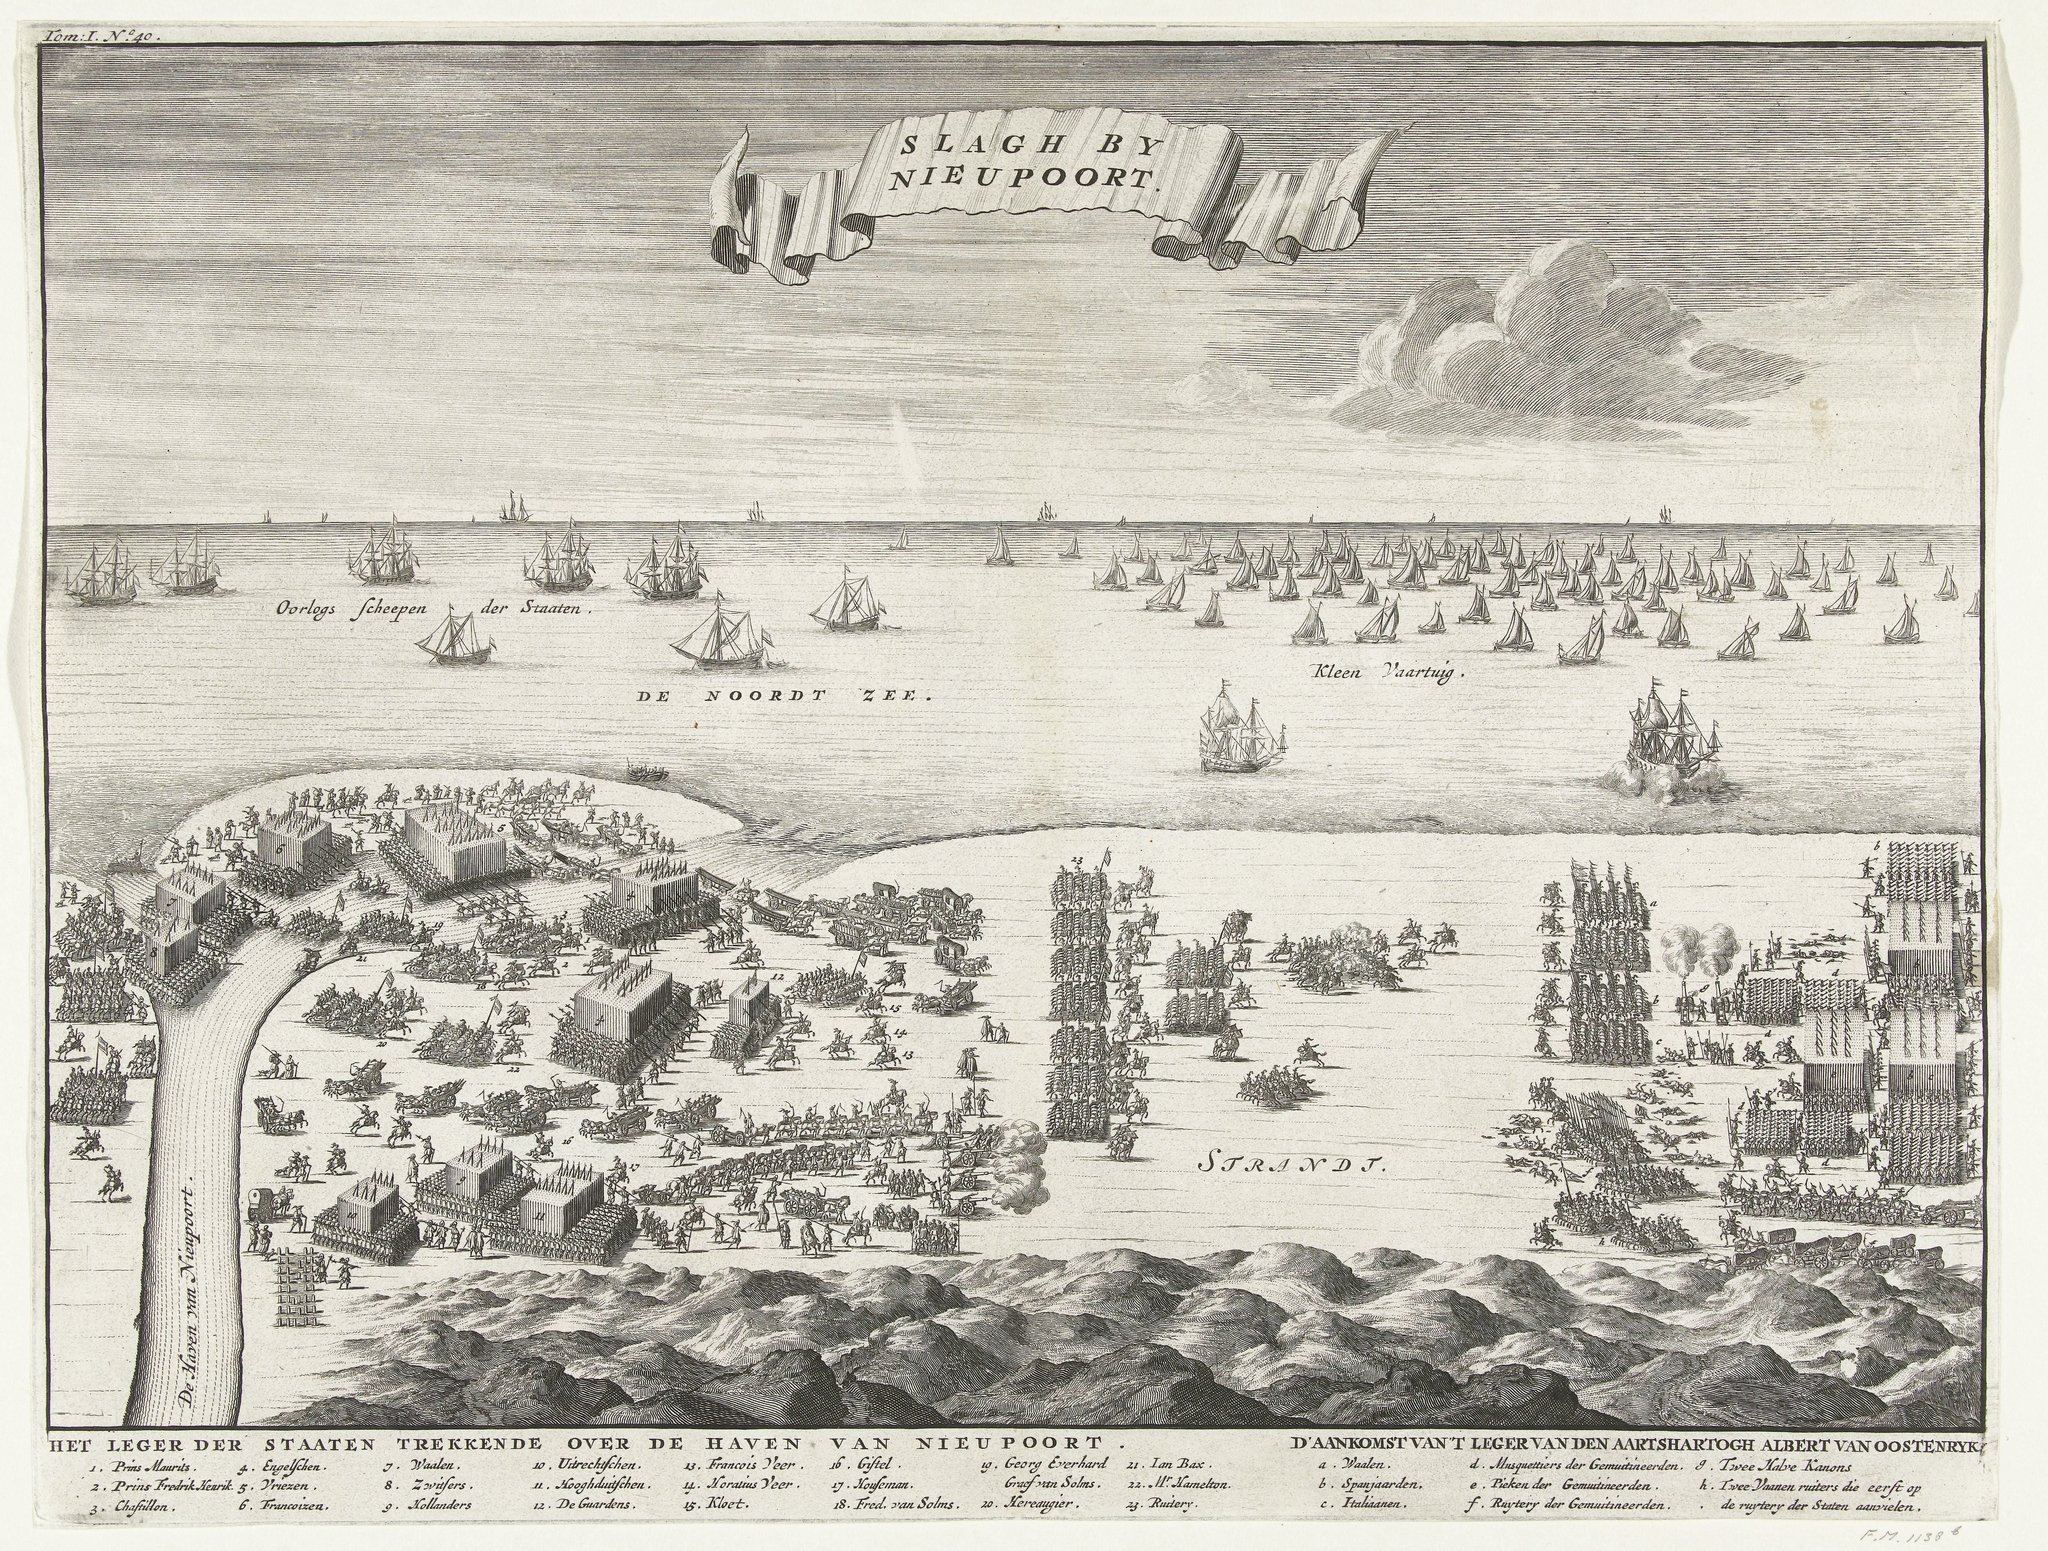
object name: print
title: Slagh by Nieupoort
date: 1682-1684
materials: paper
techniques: etching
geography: northern netherlands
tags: troop movements, transportation, battle (+ land forces), battle of nieuwpoort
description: Eerst gebruikt als illustratie in: P. Bor Christiaensz., Oorsprongk, begin, en vervolgh der Nederlandsche Oorlogen, Amsterdam 1679-1684, 4 delen. In deze staat gebruikt in: J. le Clerc, Geschiedenissen der Vereenigde Nederlanden, sedert den aanvang van die Republyk tot op den Vrede van Utrecht in 't jaar 1713 en het Tractaat van Barriere in 't jaar 1715 gesloten, Z. Chatelain, Amsterdam 1730, 3 delen, Tom. I, No. 40. Kopie naar de grote prent toegeschreven aan Floris Balthasarsz. van Berckenrode.